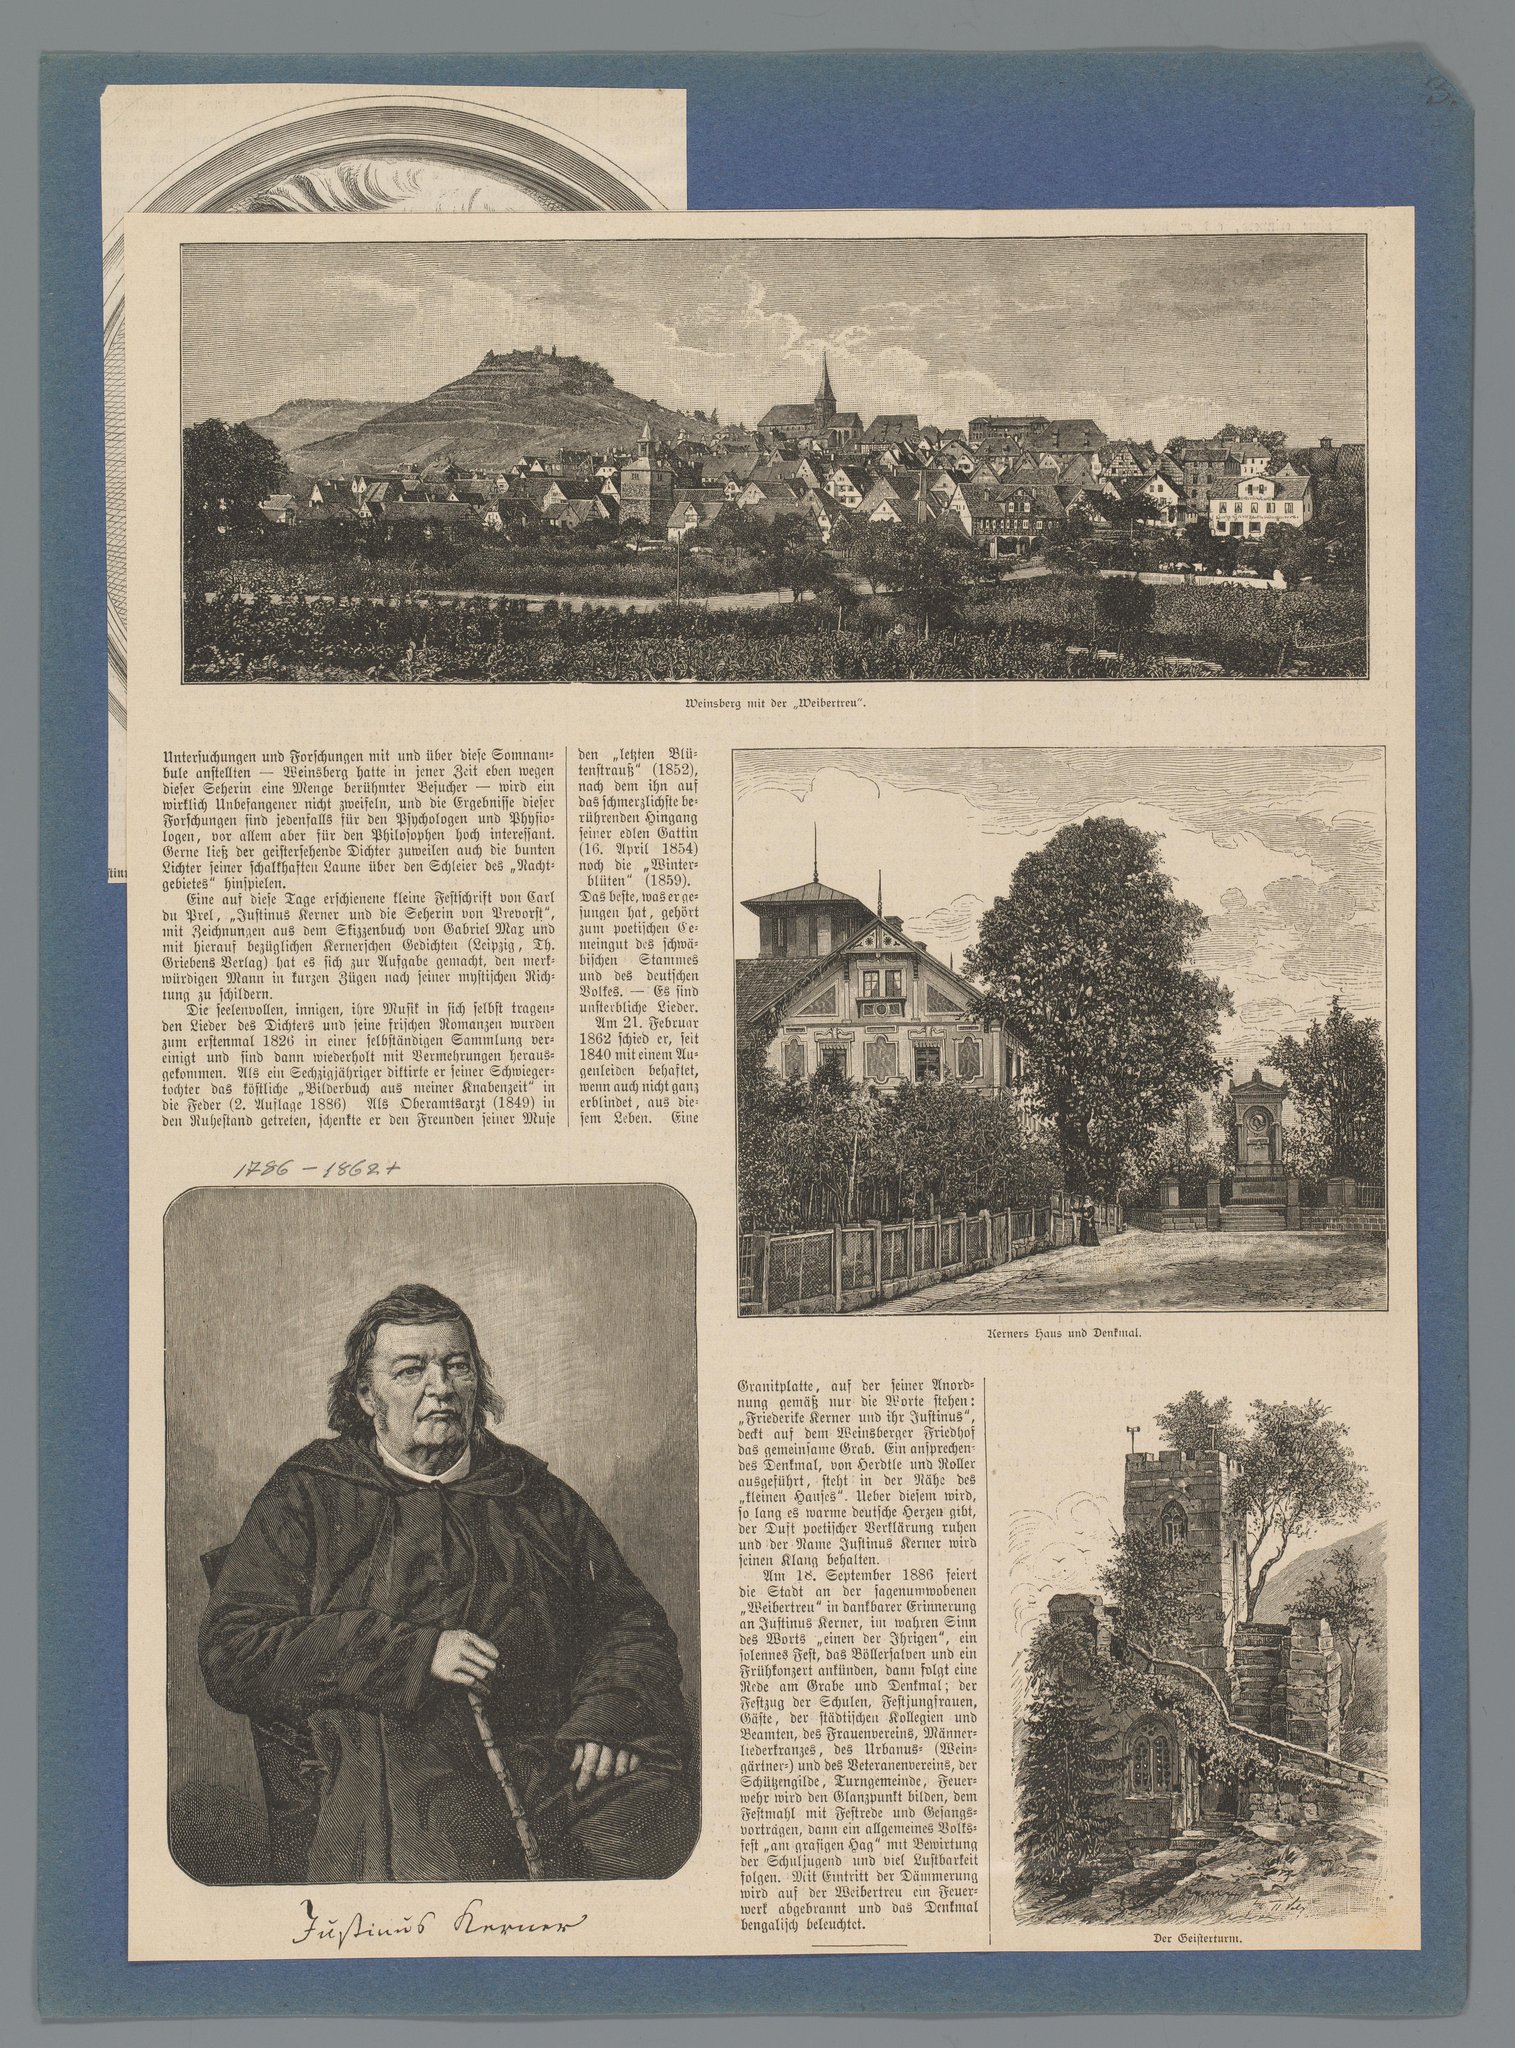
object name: sheet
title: Blad met twee portretten van Justinus Andreas Christian Kerner en afbeeldingen van landschappen en stadsgezichten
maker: Anonymous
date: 1850-1900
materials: paper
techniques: letterpress printing, snipping, engraving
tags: city-view, and landscape with man-made constructions, historical persons, physician, doctor (+ portrait of scholar, scientist)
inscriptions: number: ‘3.’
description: Met facsimile handtekening van de geportretteerde.